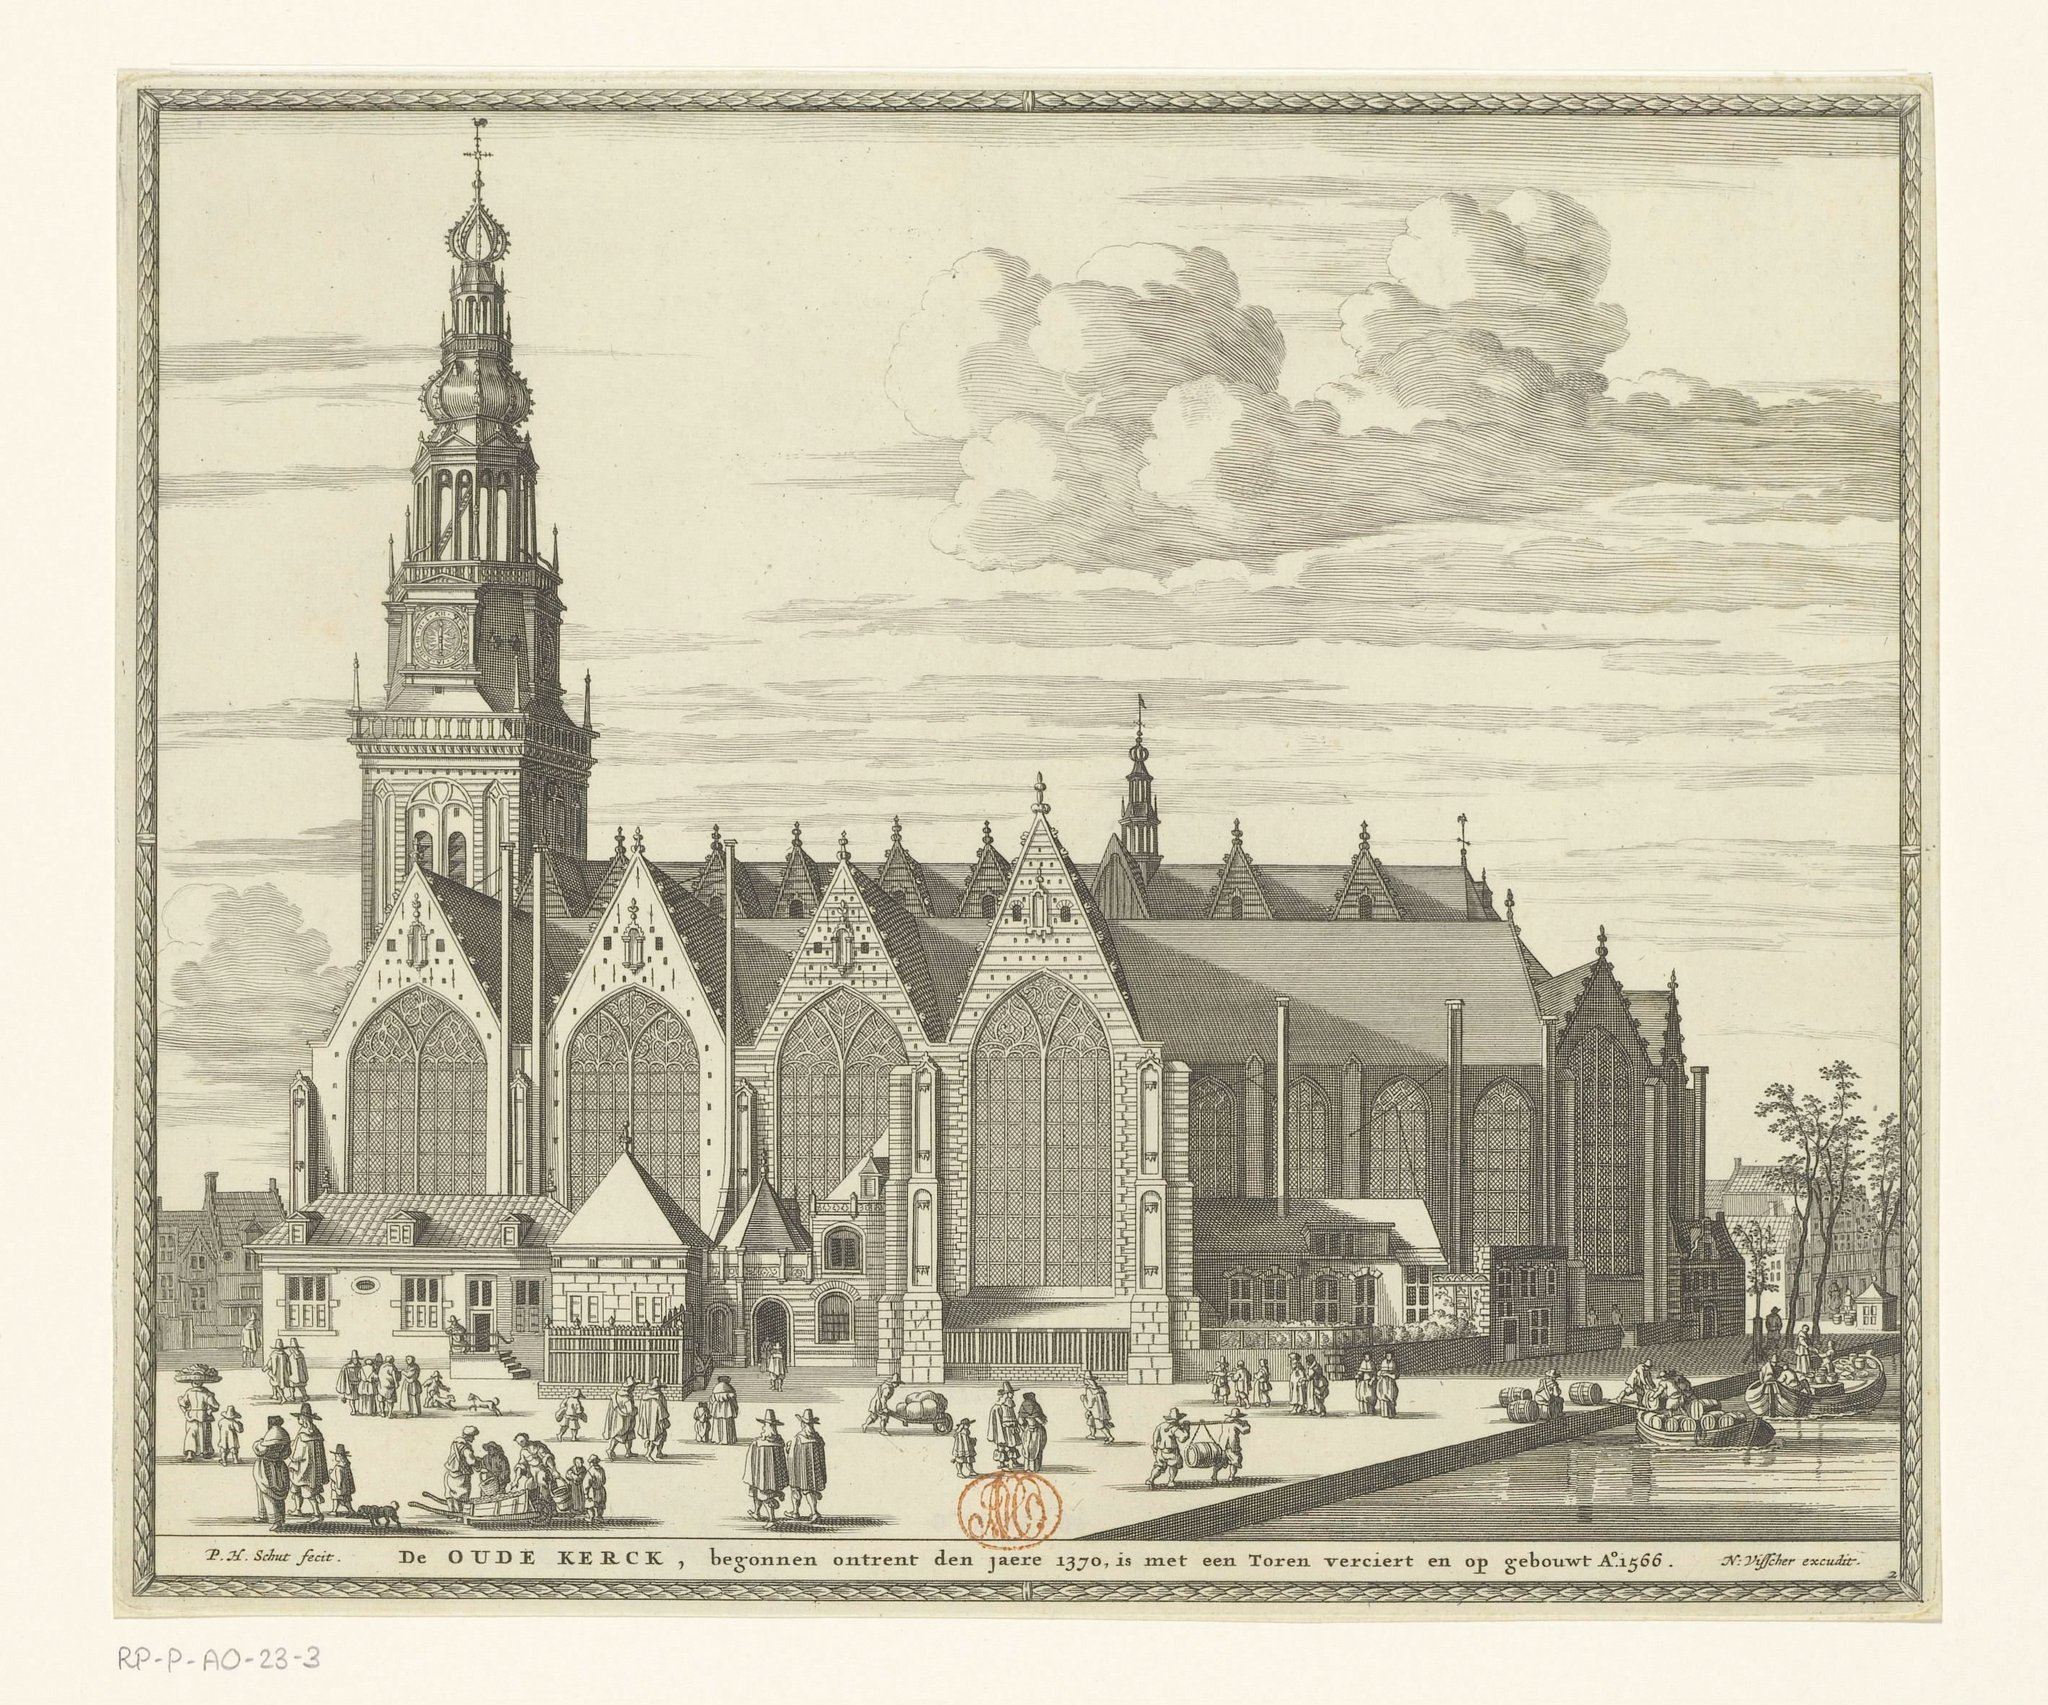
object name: print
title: De Oude Kerck, begonnen ontrent den jaere 1370, is met een Toren verciert en op gebouwt Ao. 1566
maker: pieter hendricksz. schut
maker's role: print maker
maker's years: 1618-1660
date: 1662-1720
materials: paper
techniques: engraving, etching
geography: amsterdam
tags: church (exterior), street (+ city(-scape) with figures, staffage)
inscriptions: collector's mark: Lugt 195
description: Ook uitgegeven als onderdeel van sierrand van een wandkaart van Amsterdam, zie RP-P-AO-20-45. Latere staat uitgegeven door Covens & Mortier.